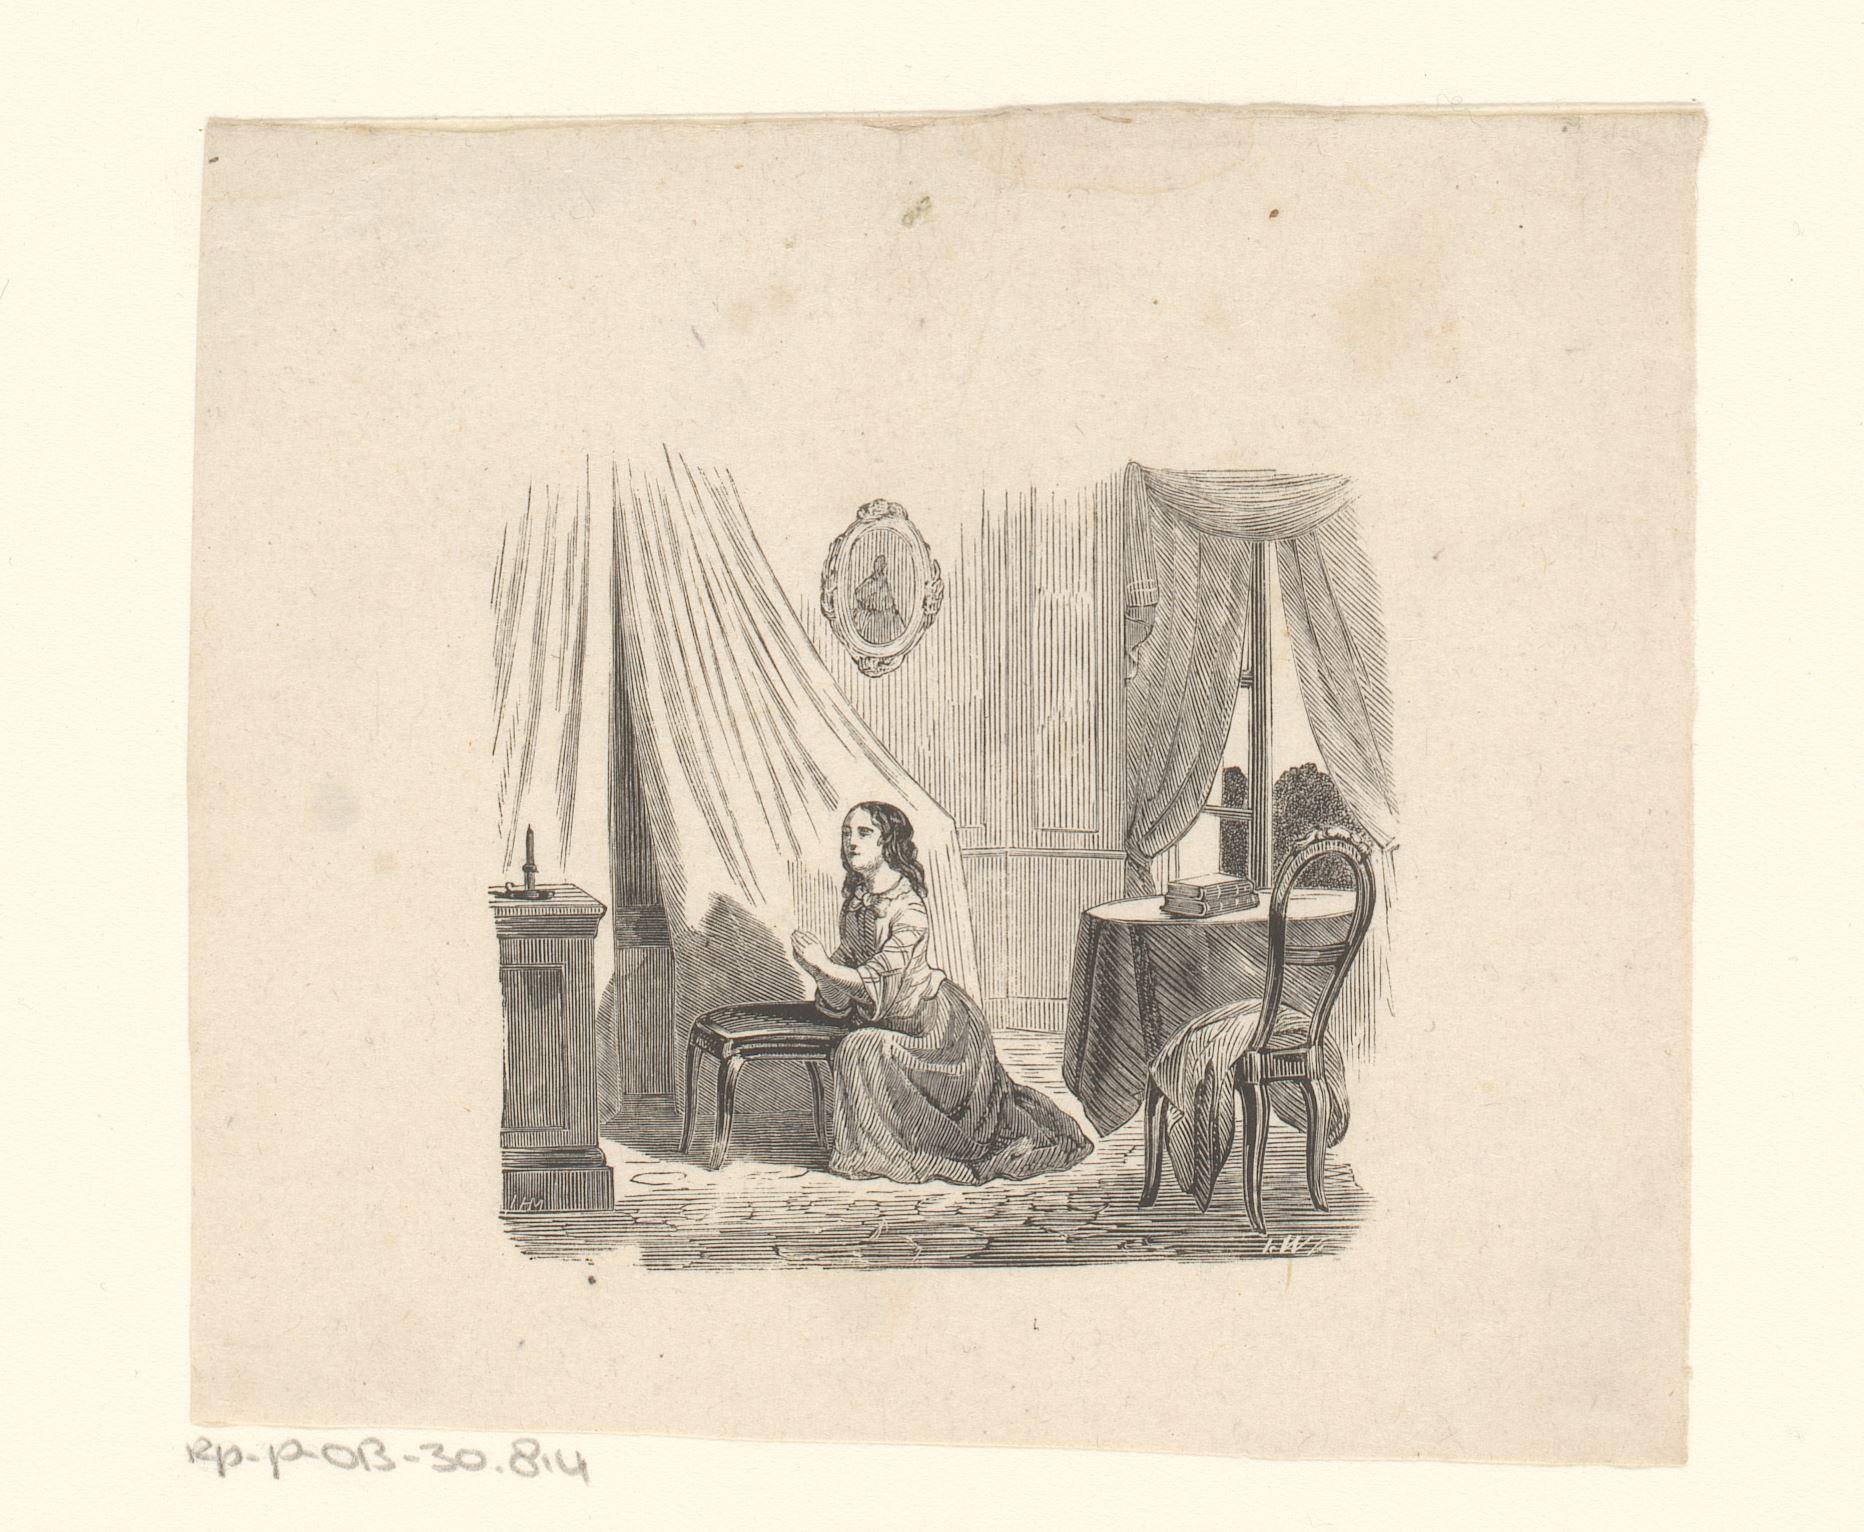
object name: print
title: Interieur met knielende jonge vrouw in gebed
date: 1836-1912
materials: paper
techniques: engraving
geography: netherlands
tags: adolescent, young woman, maiden (+ kneeling), one person praying